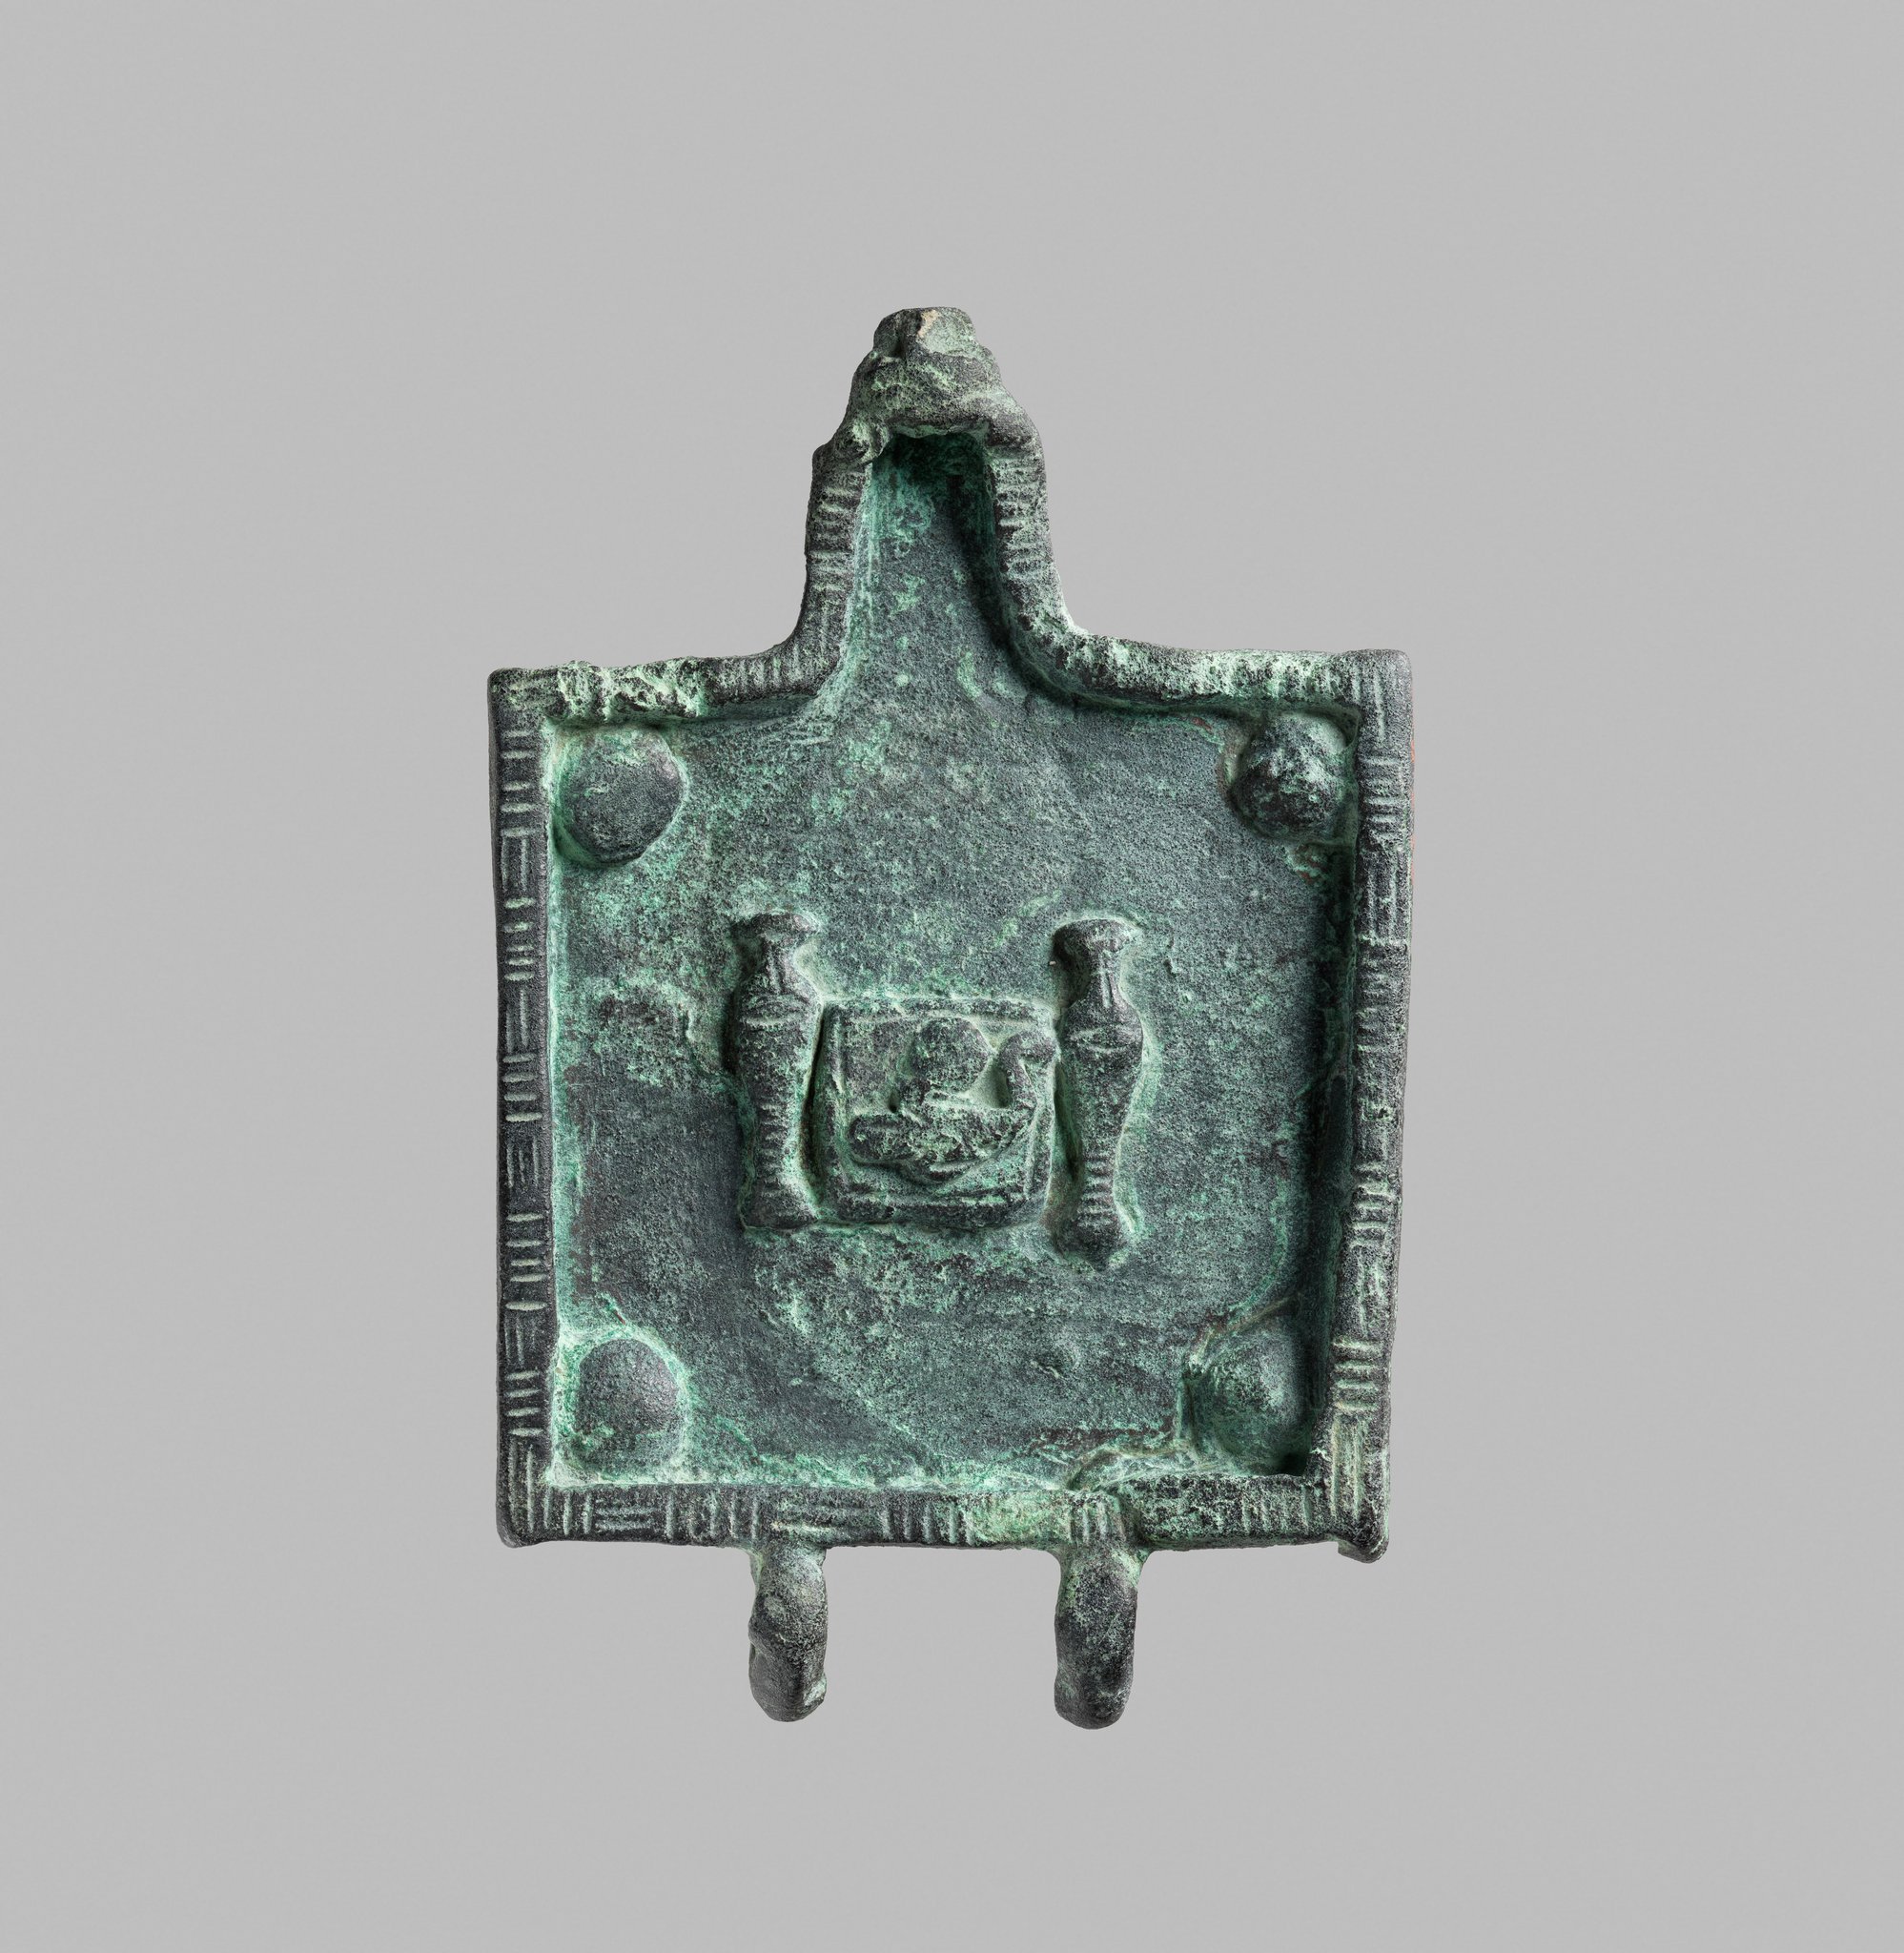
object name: miniature offering table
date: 400-200 BCE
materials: bronze, copper alloy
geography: egypt